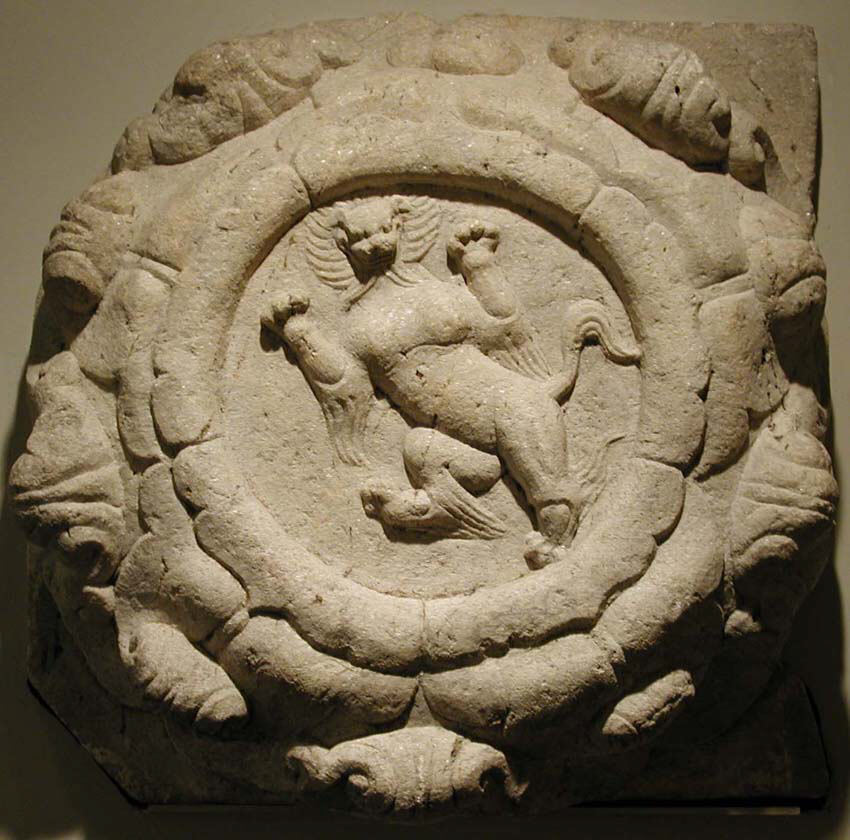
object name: architectural detail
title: Pair of decorative medallions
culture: chinese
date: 901-1100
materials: stone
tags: mythical creatures